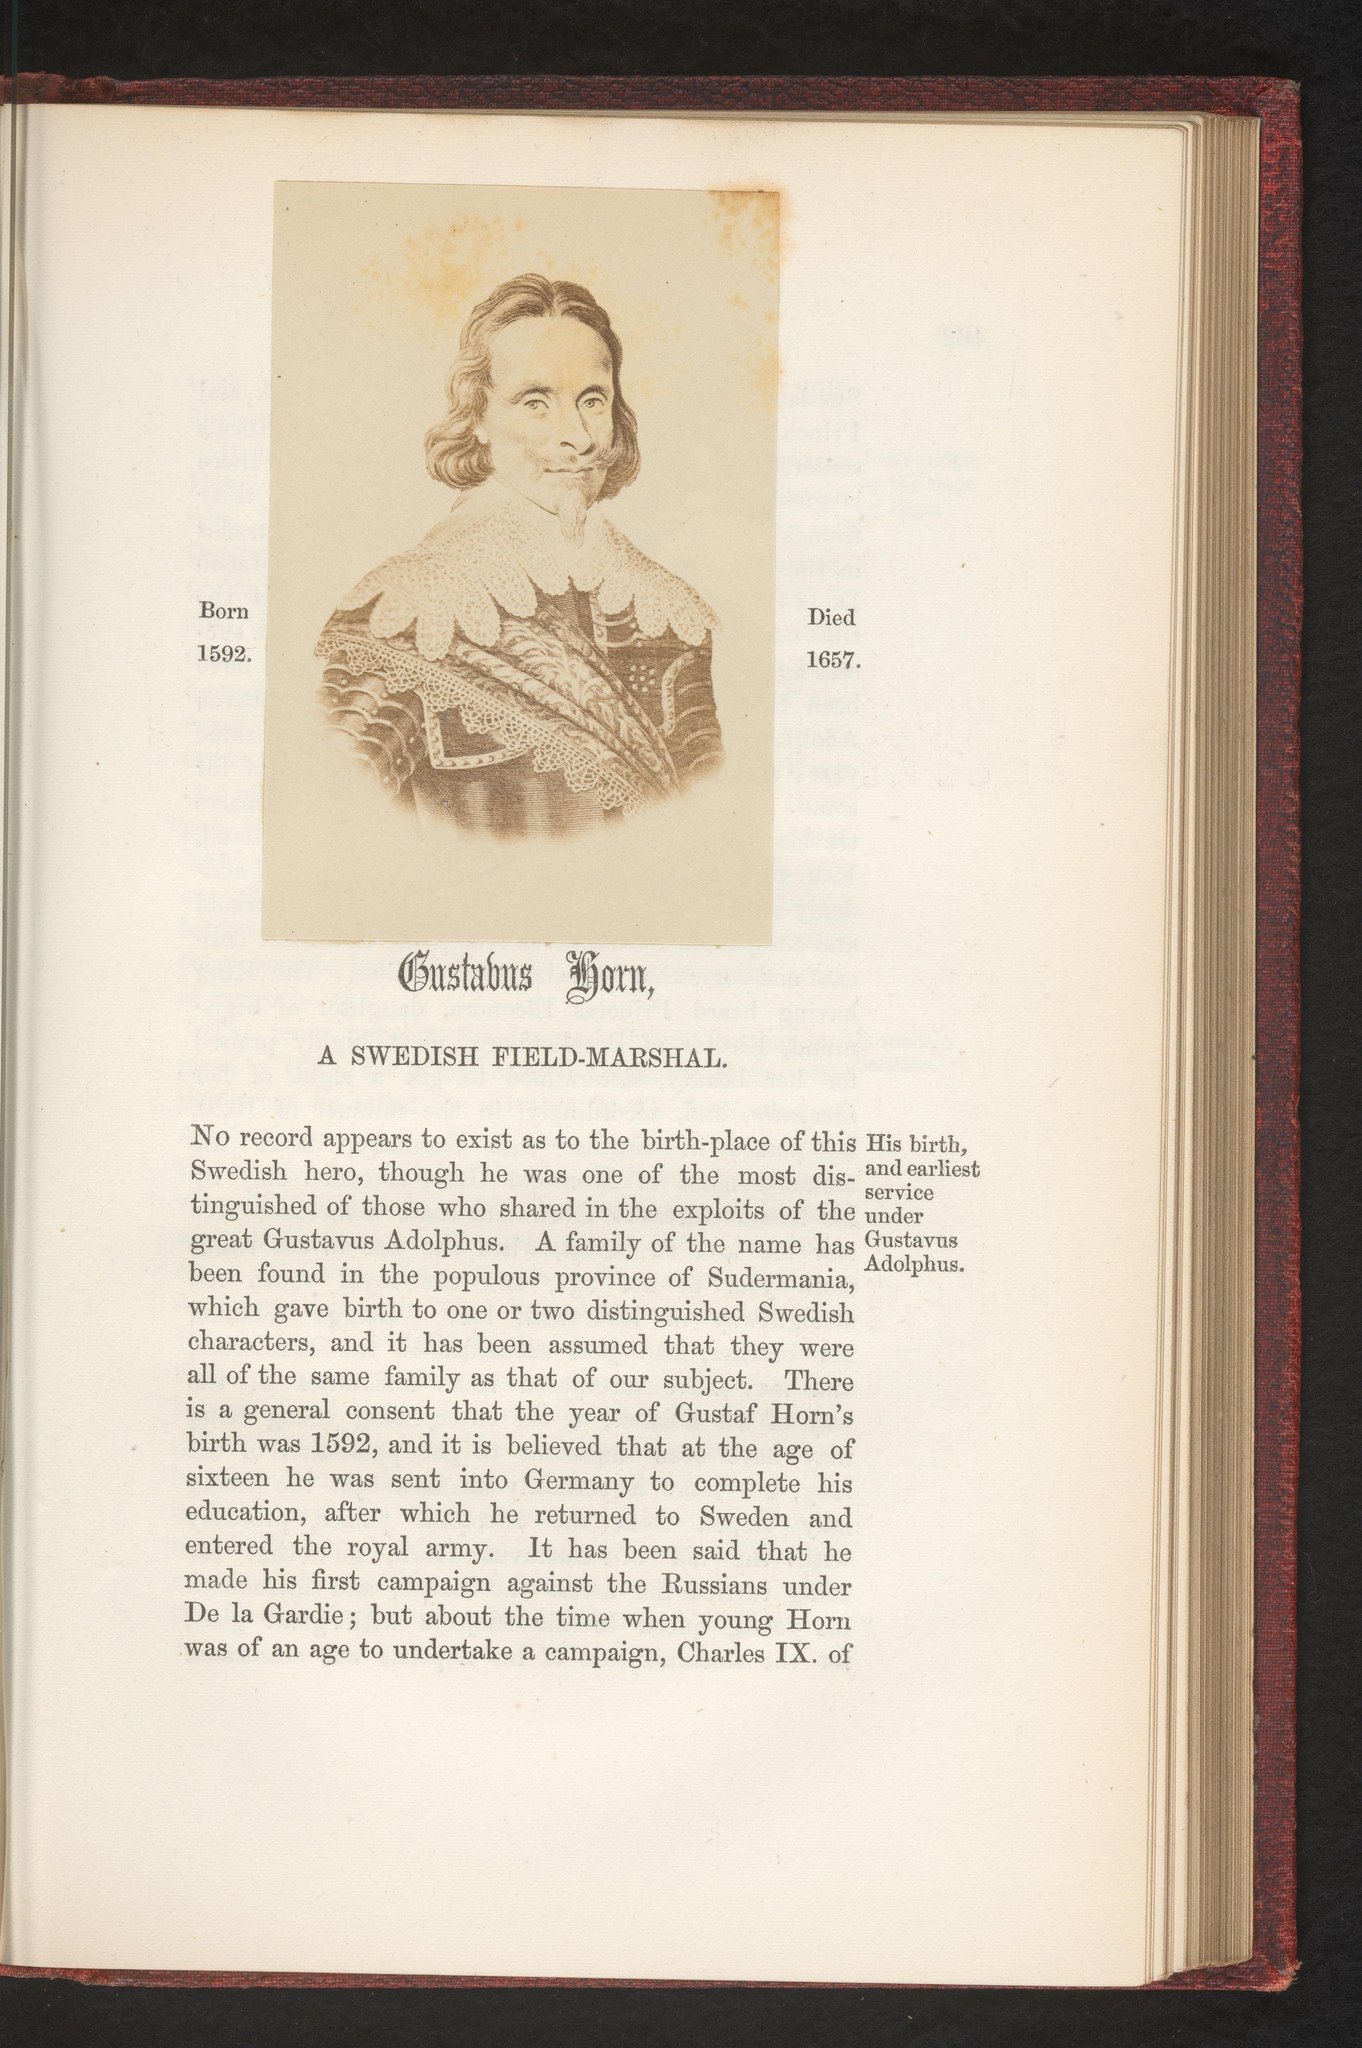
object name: reproduction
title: Gustavus Horn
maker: Anonymous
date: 1860-1865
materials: photographic support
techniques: albumen print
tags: historical persons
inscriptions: inscription: ‘Born 1592/ Died 1657/ A Swedish field-marshal’